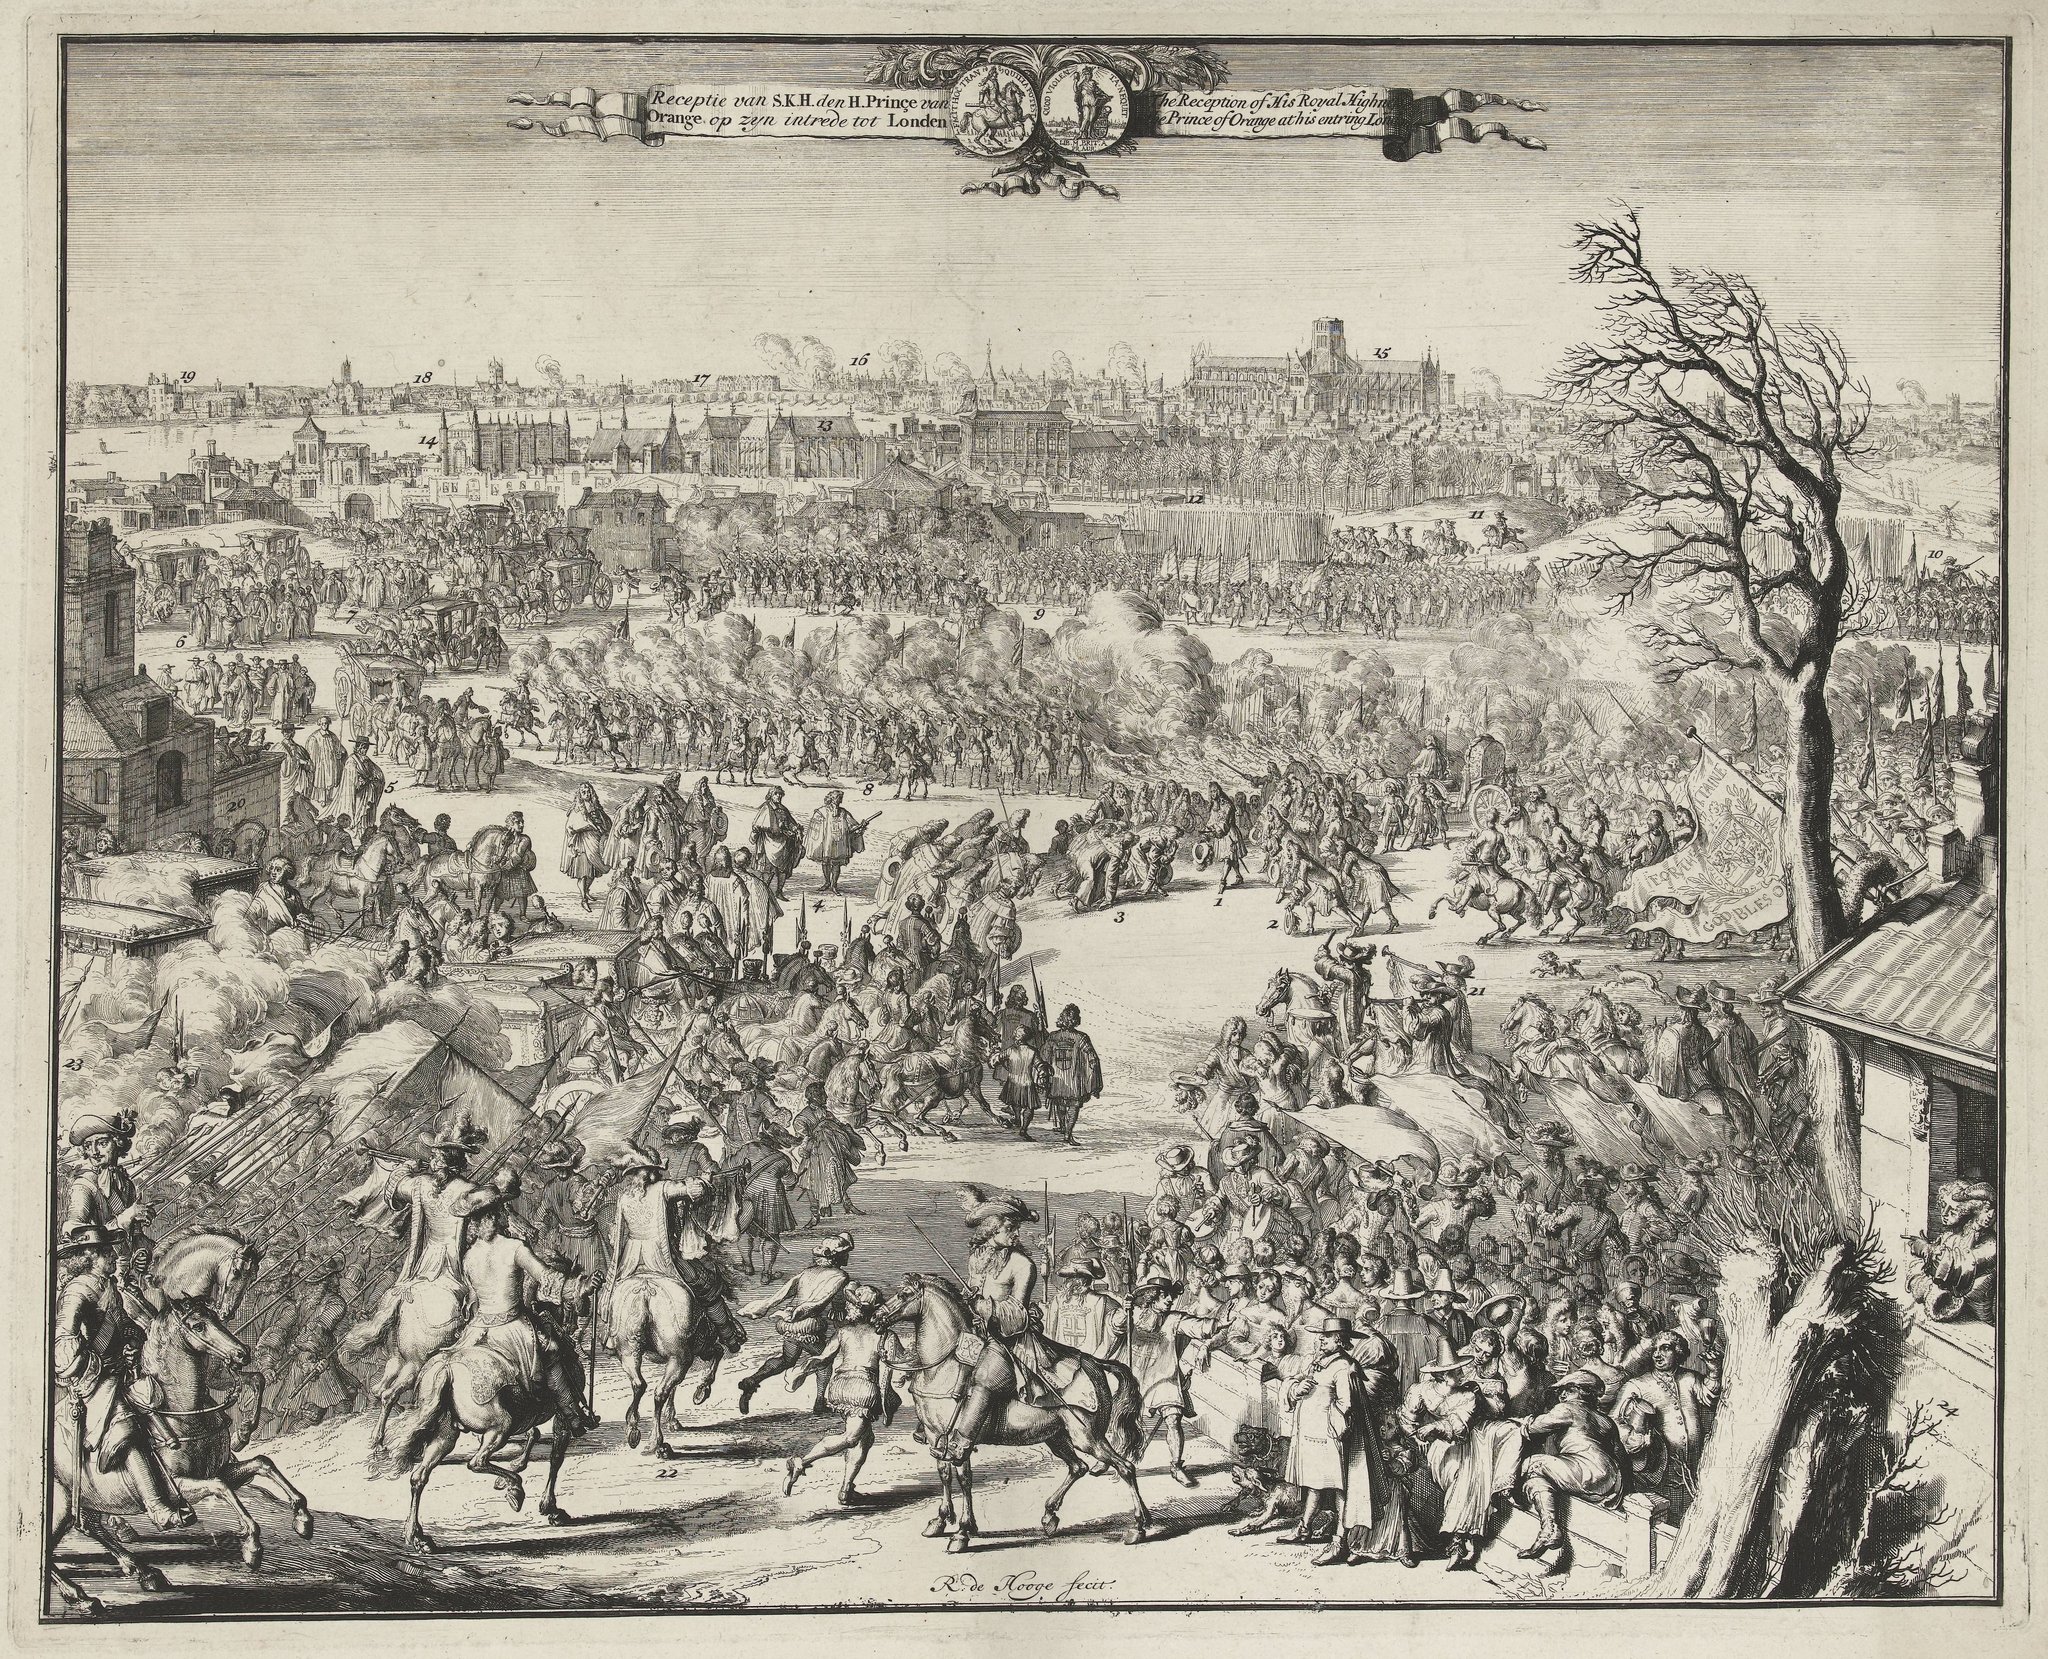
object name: print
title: The Reception of His Royal Highnesse the Prince of Orange at his entring London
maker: romeyn de hooghe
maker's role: draughtsman, goldsmith, painter, print maker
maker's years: 1645-1708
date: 1689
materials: paper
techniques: etching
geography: netherlands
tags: the hague, william iii (prince of orange and king of england, scotland, and ireland), triumphal entry and public reception, pageant, 'entrée solennelle', 'joyeuse entrée', london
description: Feestelijk ontvangst van de prins van Oranje bij zijn intrede te Londen, 29 december 1688. Burgemeesters van Londen buigen voor de prins die uit het rijtuig is gestapt. Hierachter soldaten in formatie die saluutschoten brengen. Op de voorgrond soldaten en burgers. In de verte de stad.